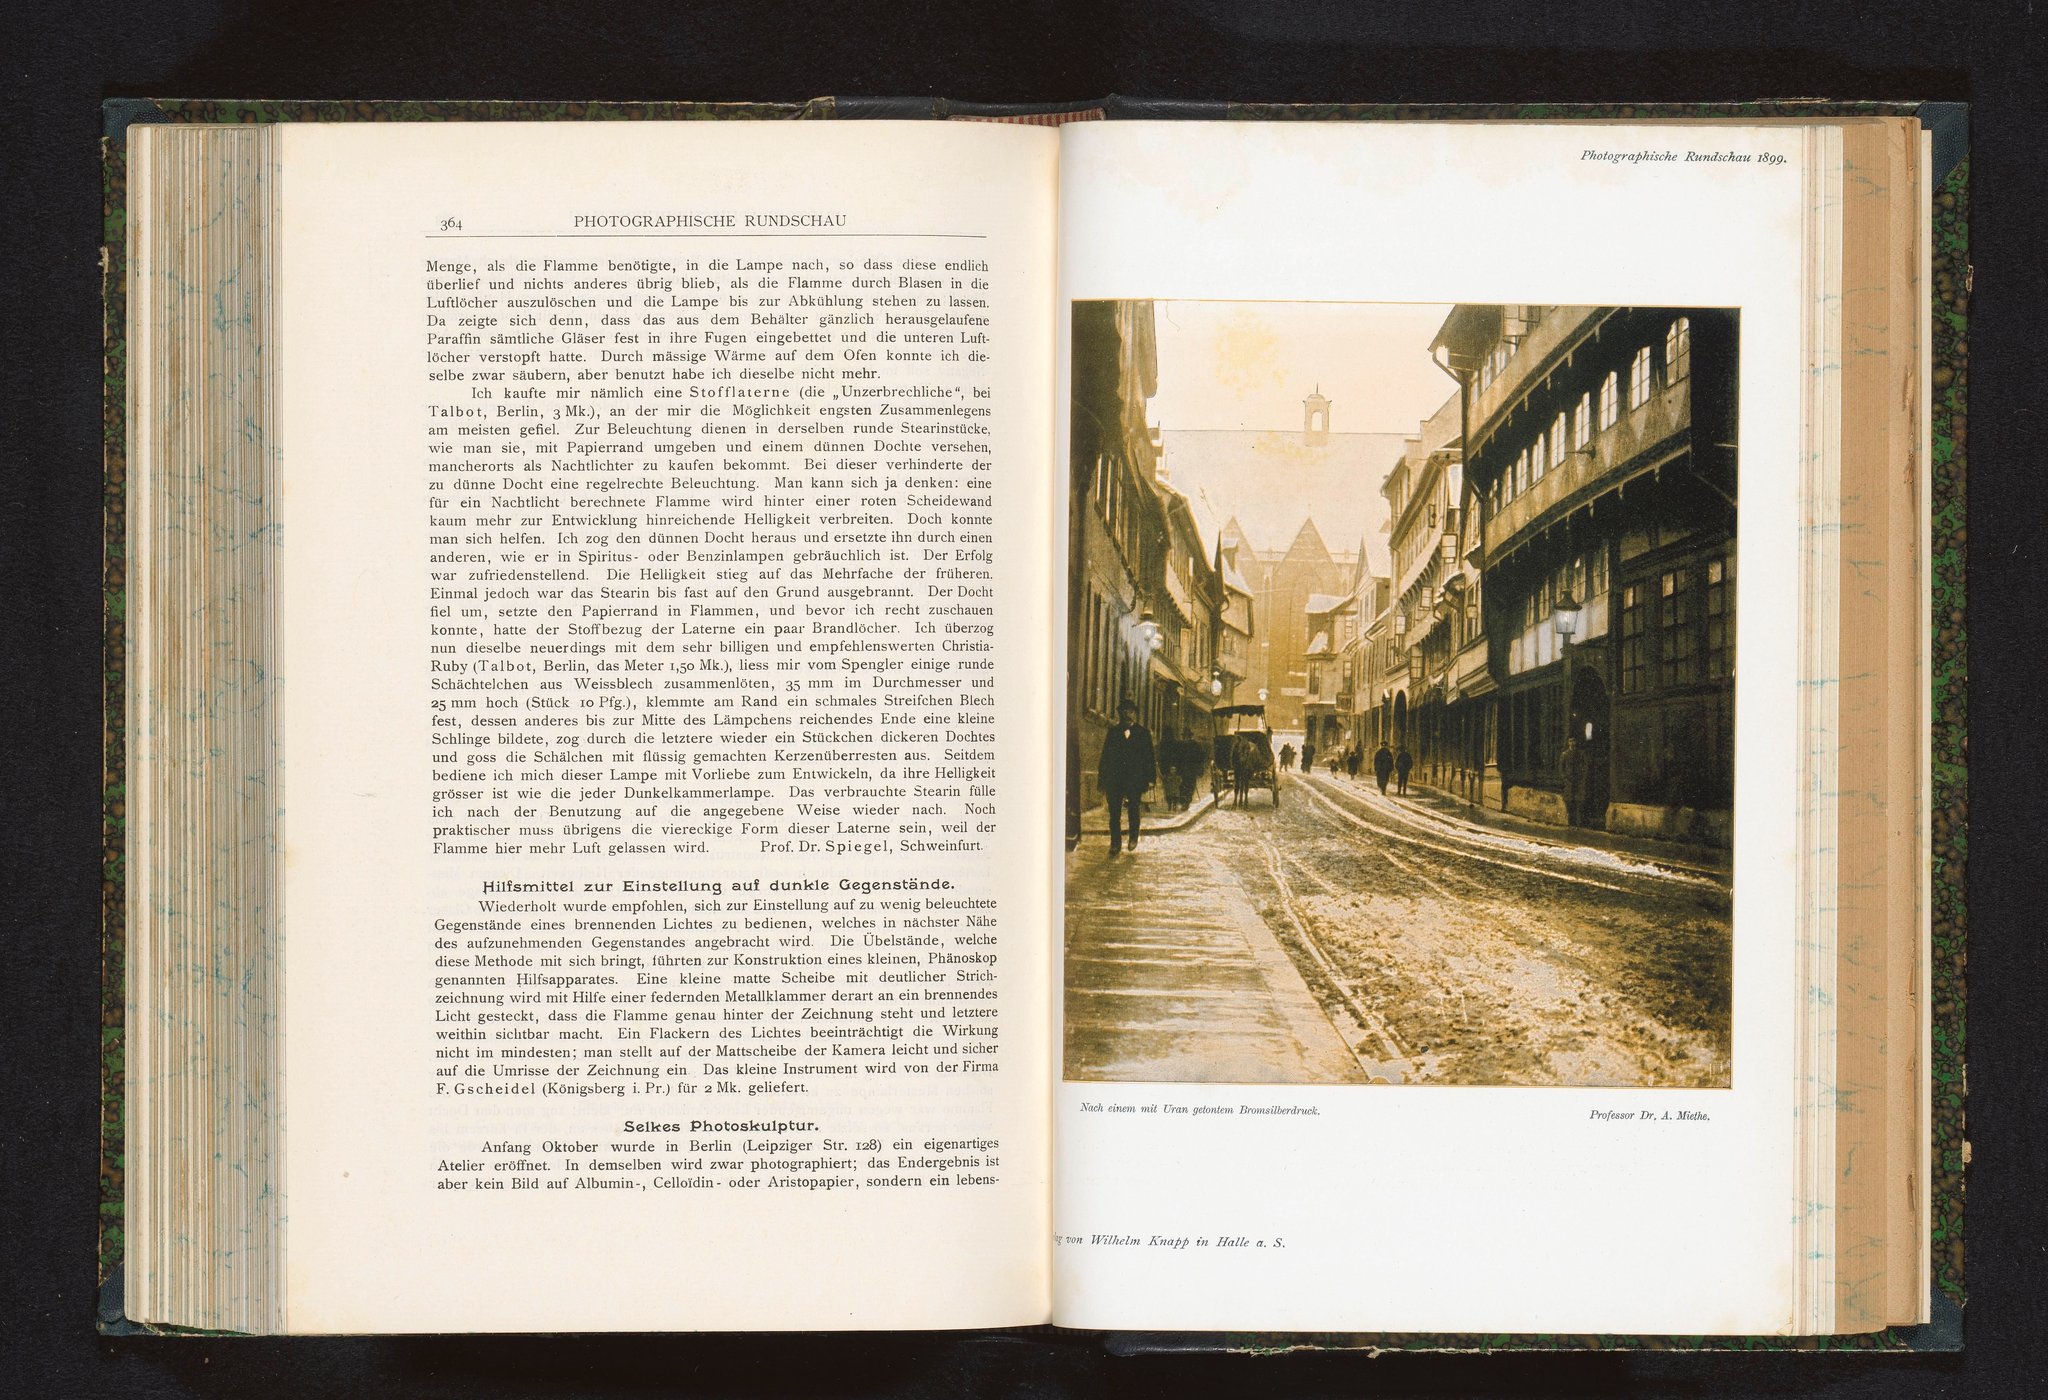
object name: photomechanical print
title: Nach einem mit Uran getontem Bromsilberdruck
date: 1894-1899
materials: paper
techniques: two-color autotype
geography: halle an der saale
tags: street